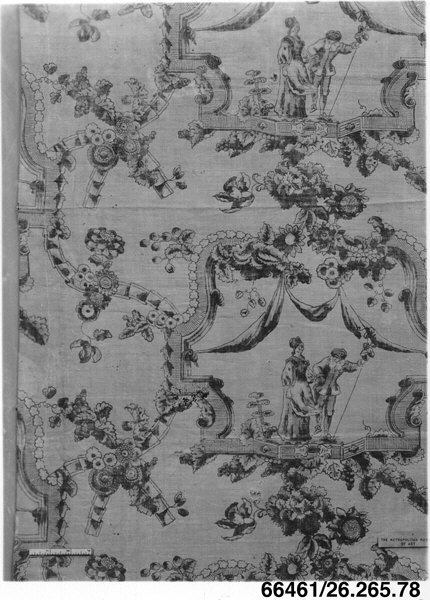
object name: furnishing textile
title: Pictorial print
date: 1775-1785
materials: linen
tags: men,women,flowers